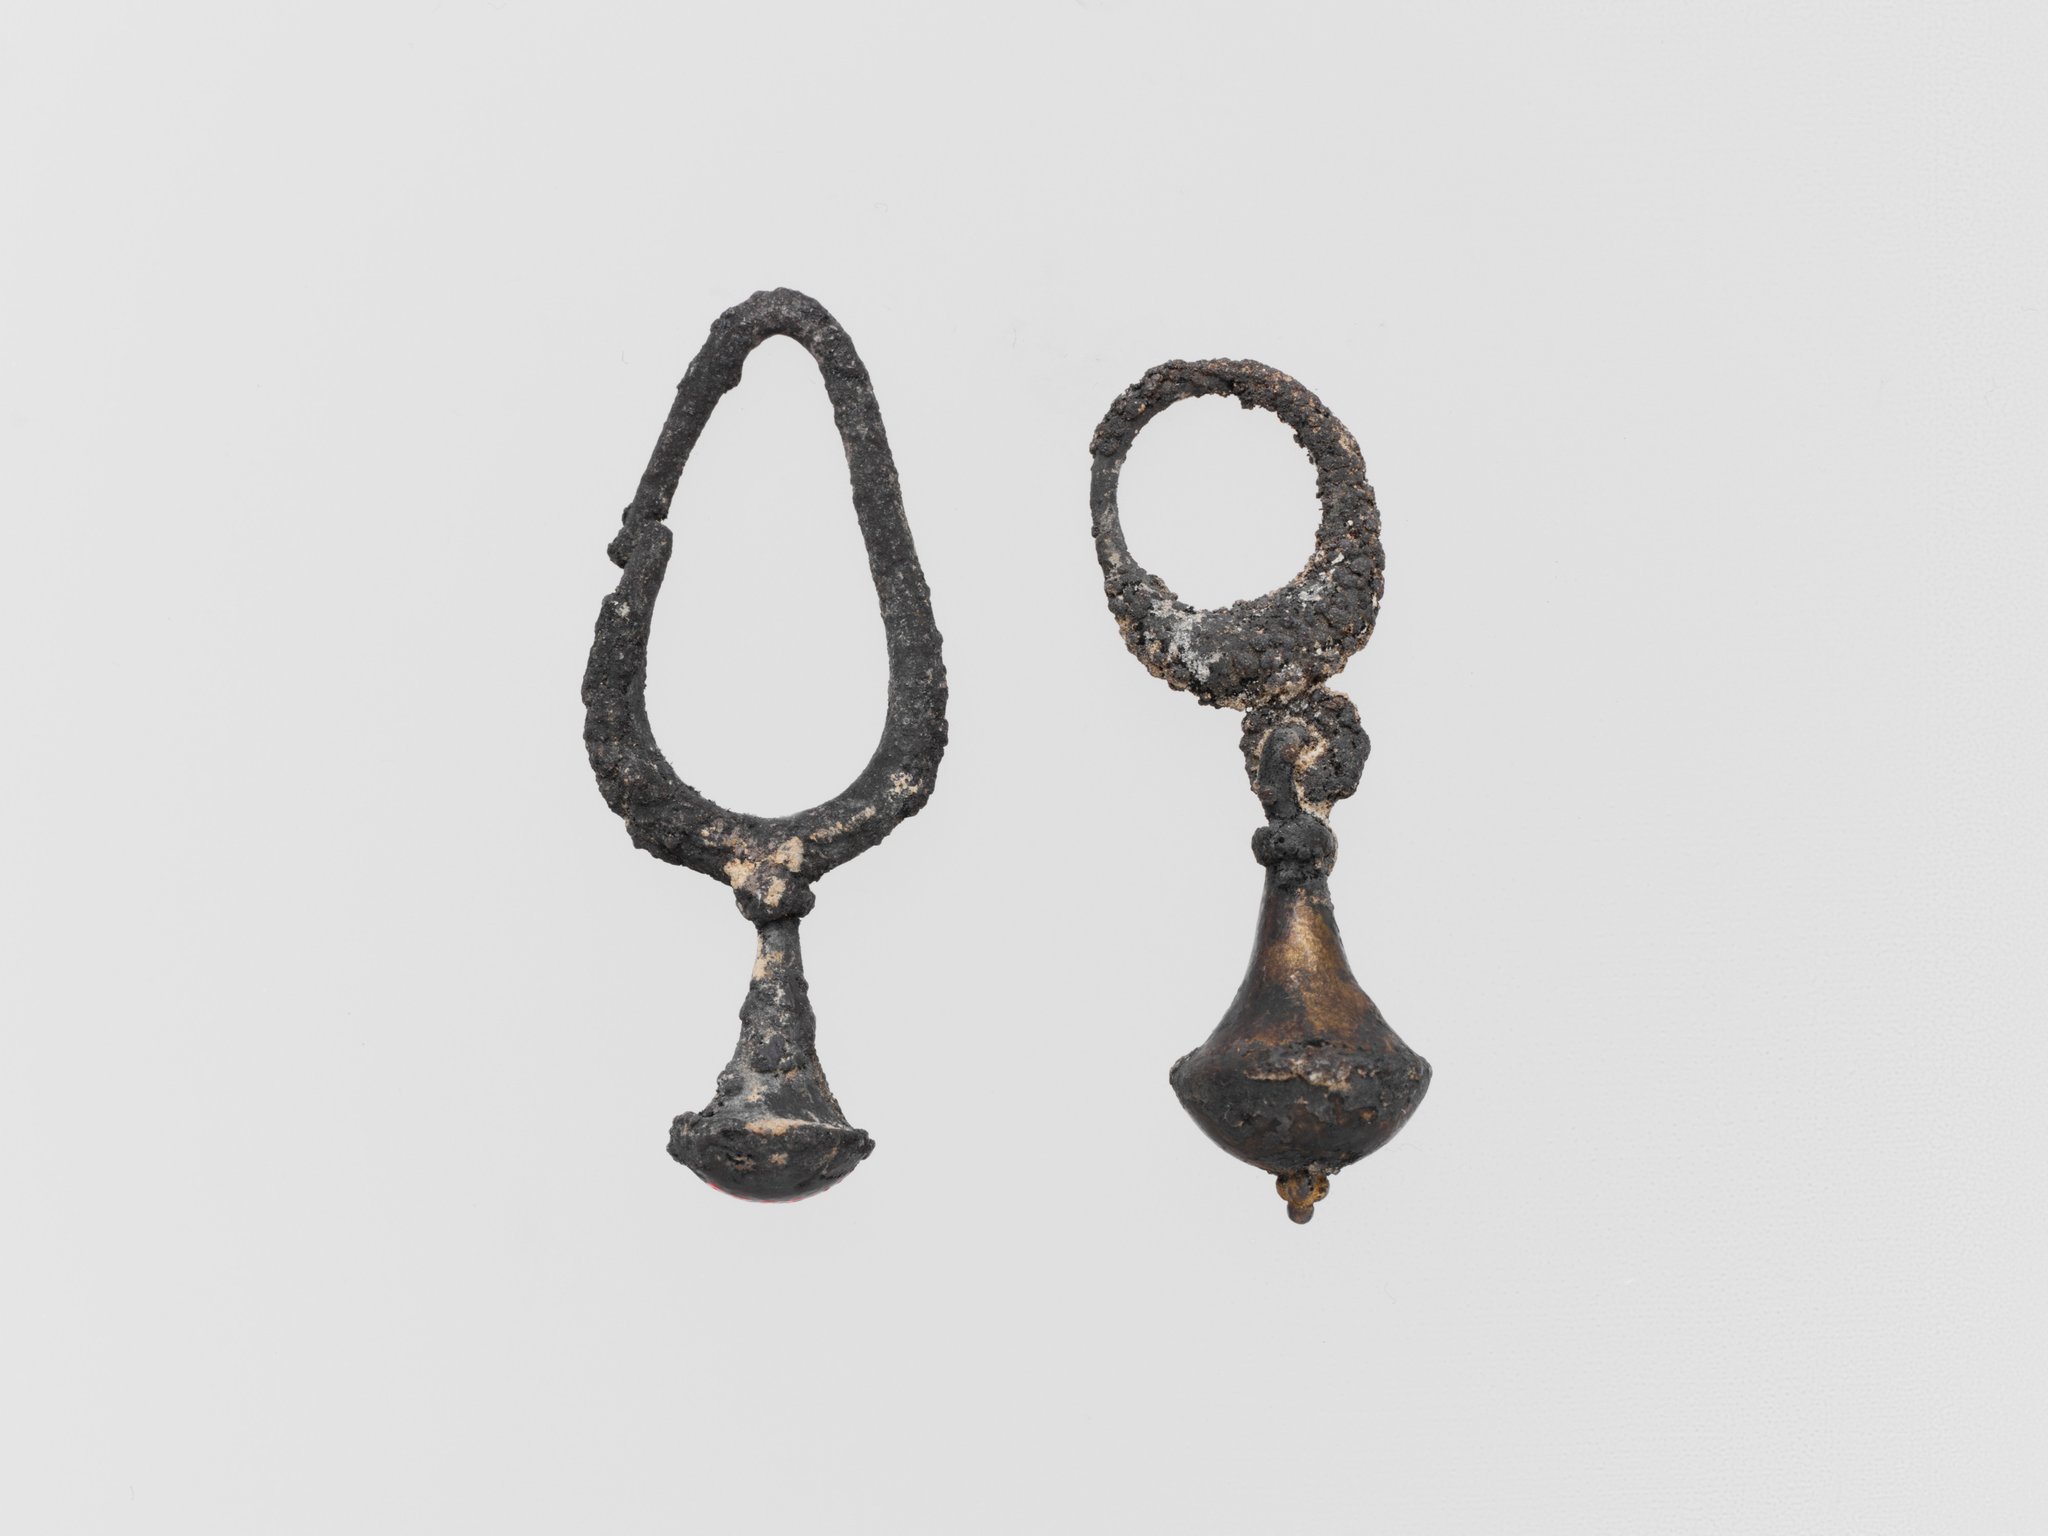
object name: earring with nail head pendant, 6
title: Silver earring with nail-head pendant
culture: cypriot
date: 600-501 BCE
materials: silver